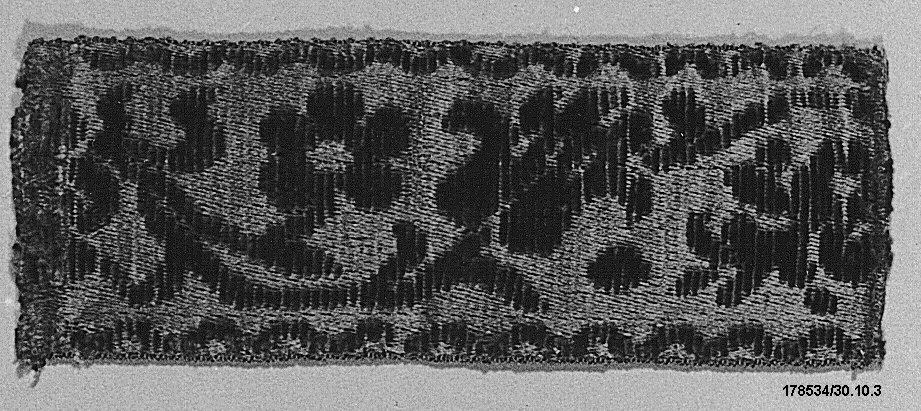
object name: border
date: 1801-1900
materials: silk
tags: flowers